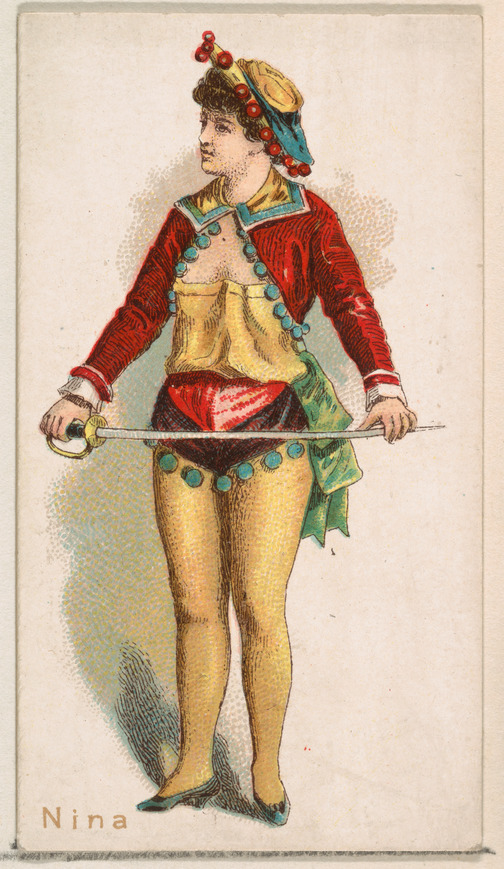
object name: print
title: Nina, from the Ballet Queens series (N182) issued by Wm. S. Kimball & Co.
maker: william s. kimball & company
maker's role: publisher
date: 1889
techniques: color lithograph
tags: profiles,women,dancers